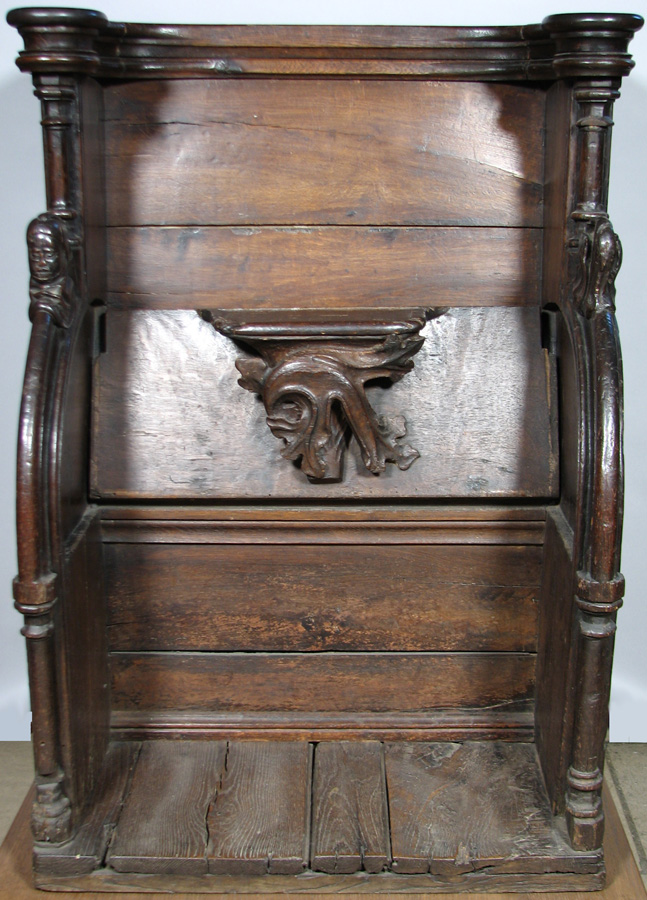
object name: choir stall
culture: french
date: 1401-1500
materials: wood